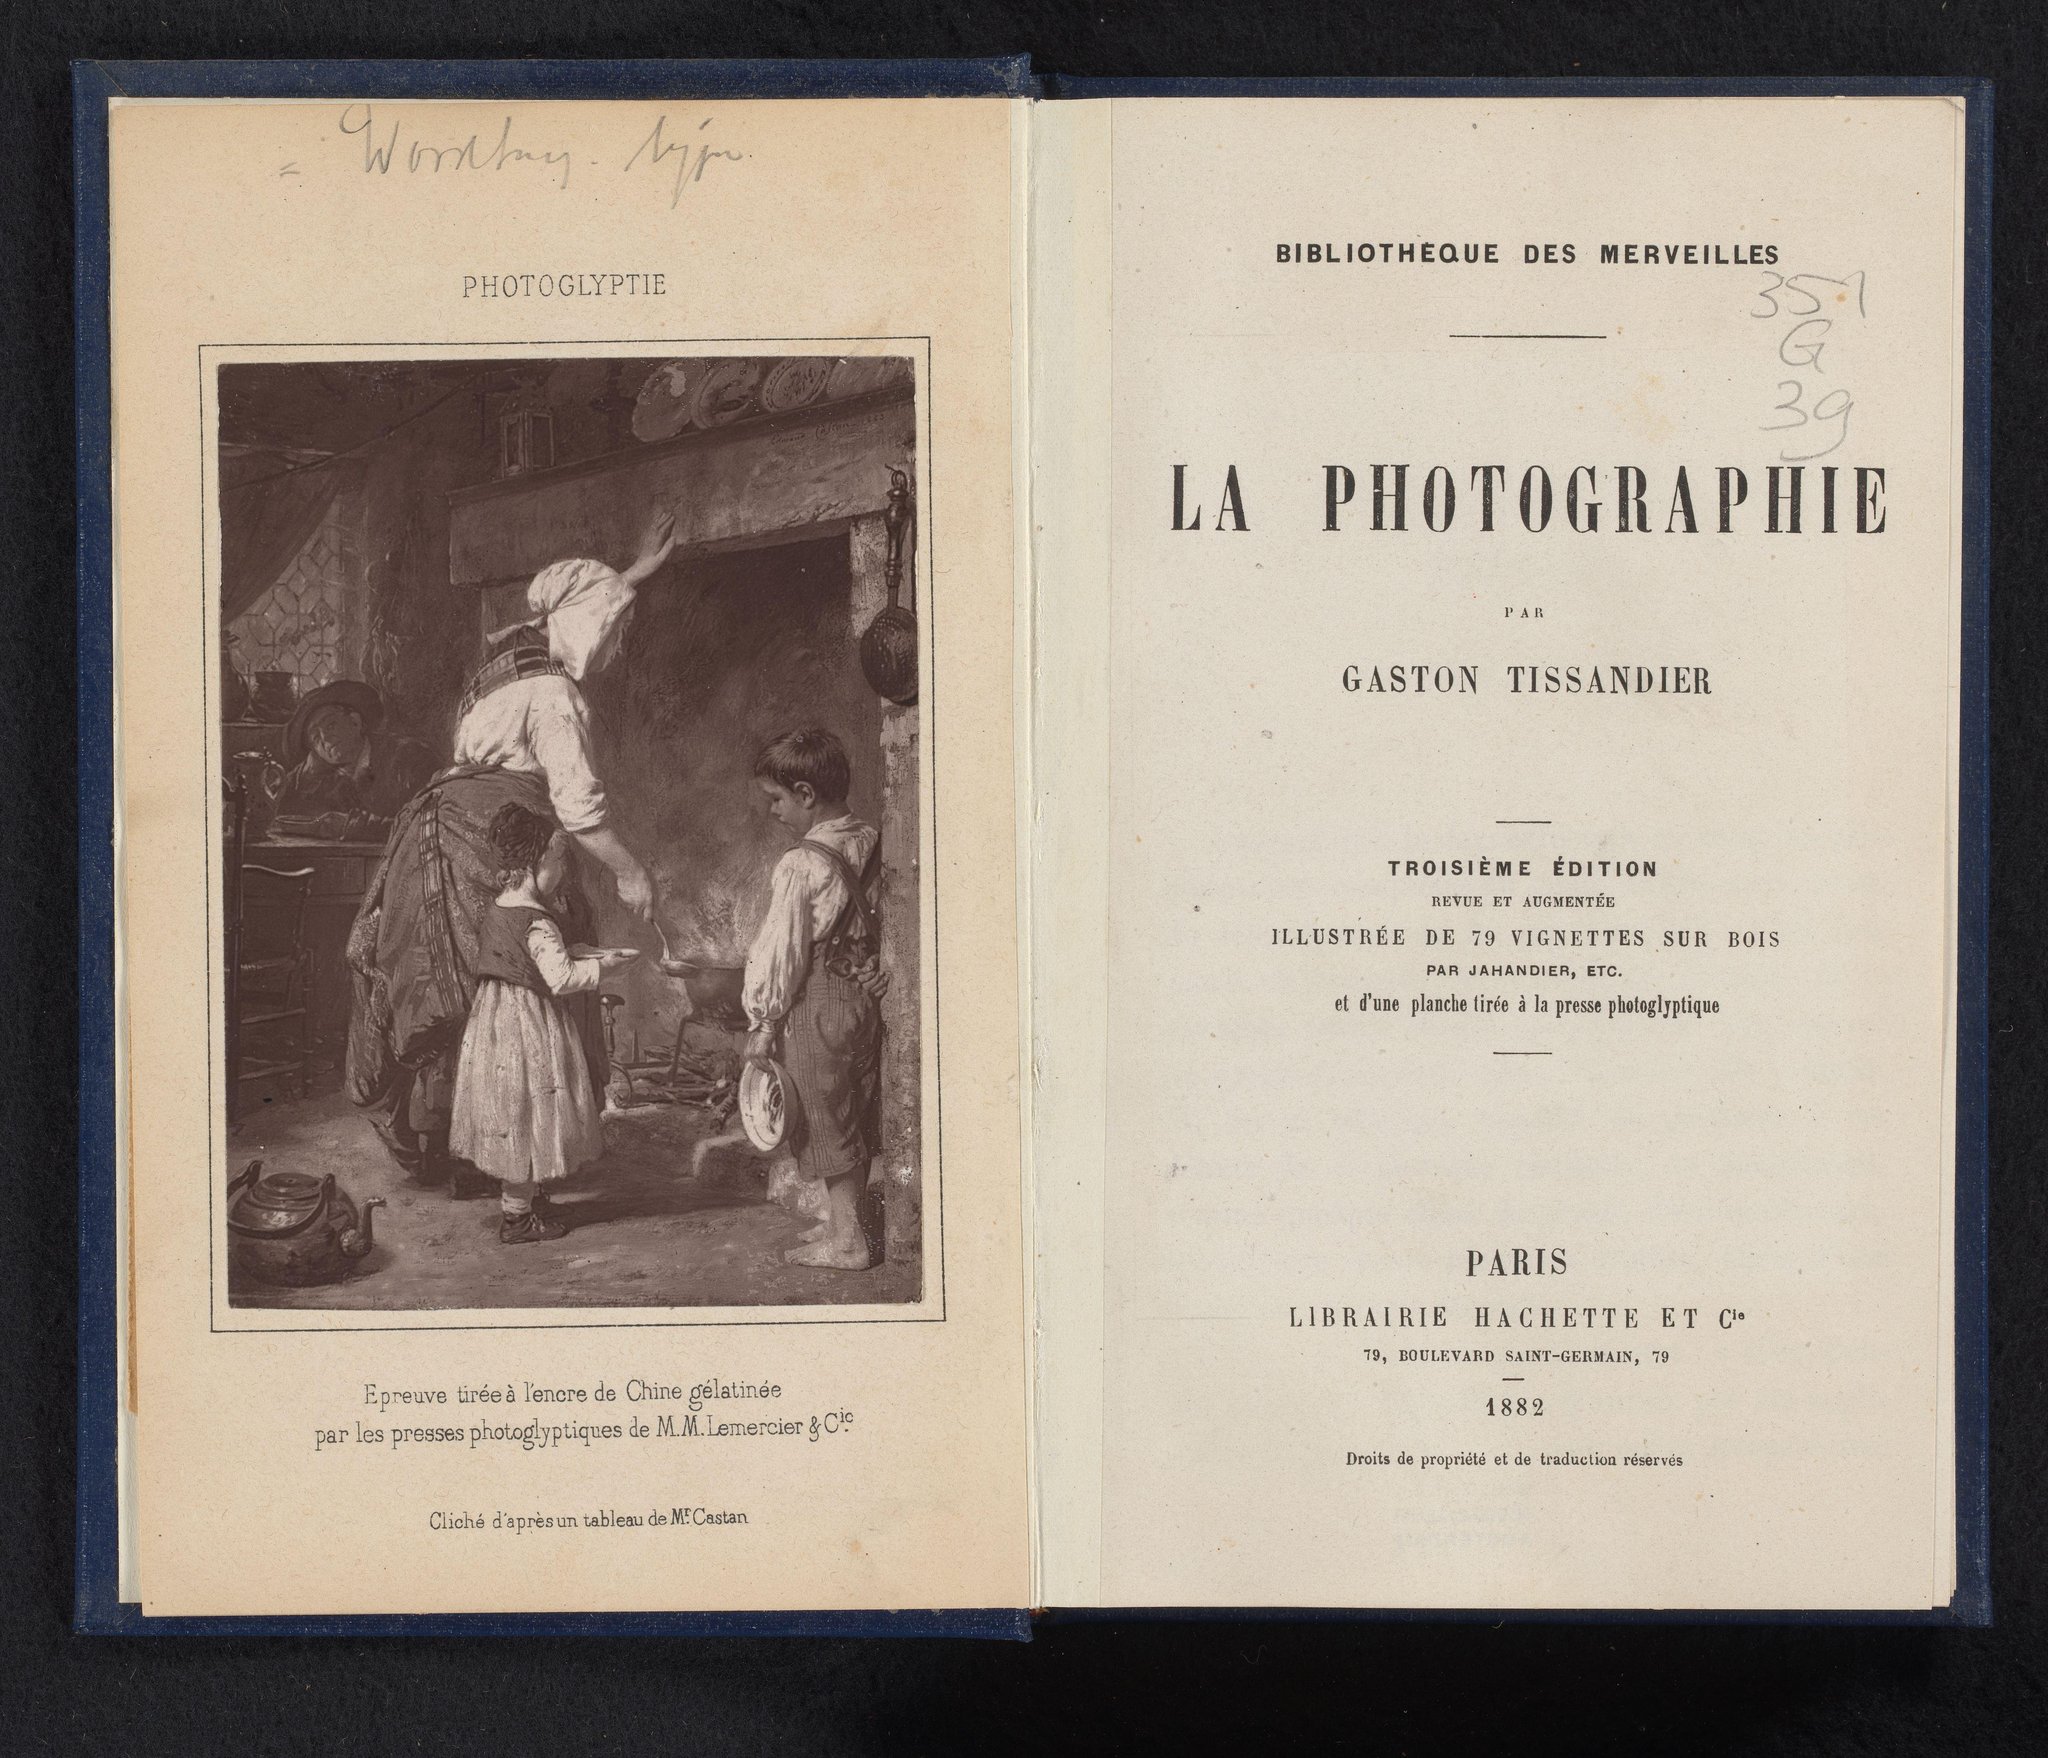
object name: page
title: Fotoreproductie van een schilderij van een moeder met twee kinderen bij een haard, door Pierre Jean Edmond Castan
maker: pierre jean edmond castan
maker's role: print maker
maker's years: 1817-1892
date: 1869-1882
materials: paper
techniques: woodburytype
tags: open hearth, fire-place, mother and child(ren), woman and child(ren) (family group)